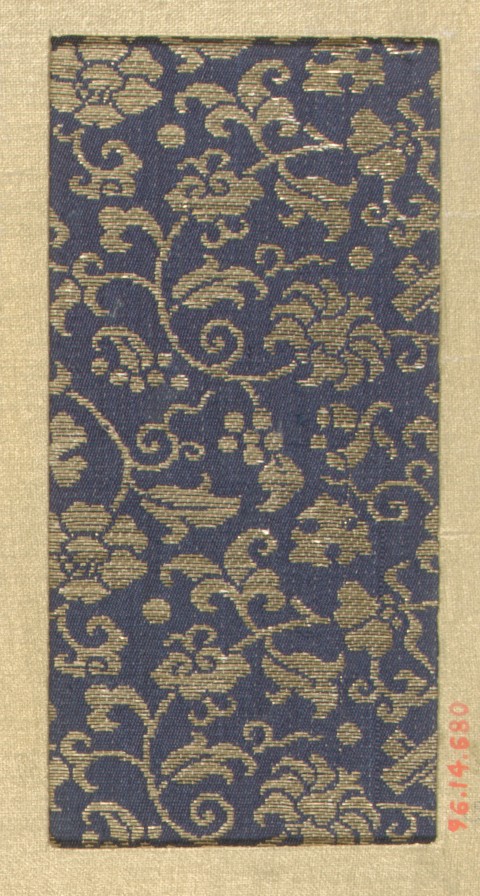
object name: piece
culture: japanese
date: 1701-1900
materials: silk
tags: flowers